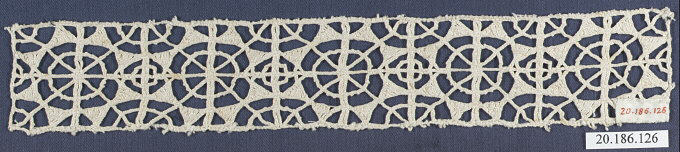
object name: insertion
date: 1501-1600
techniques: lace